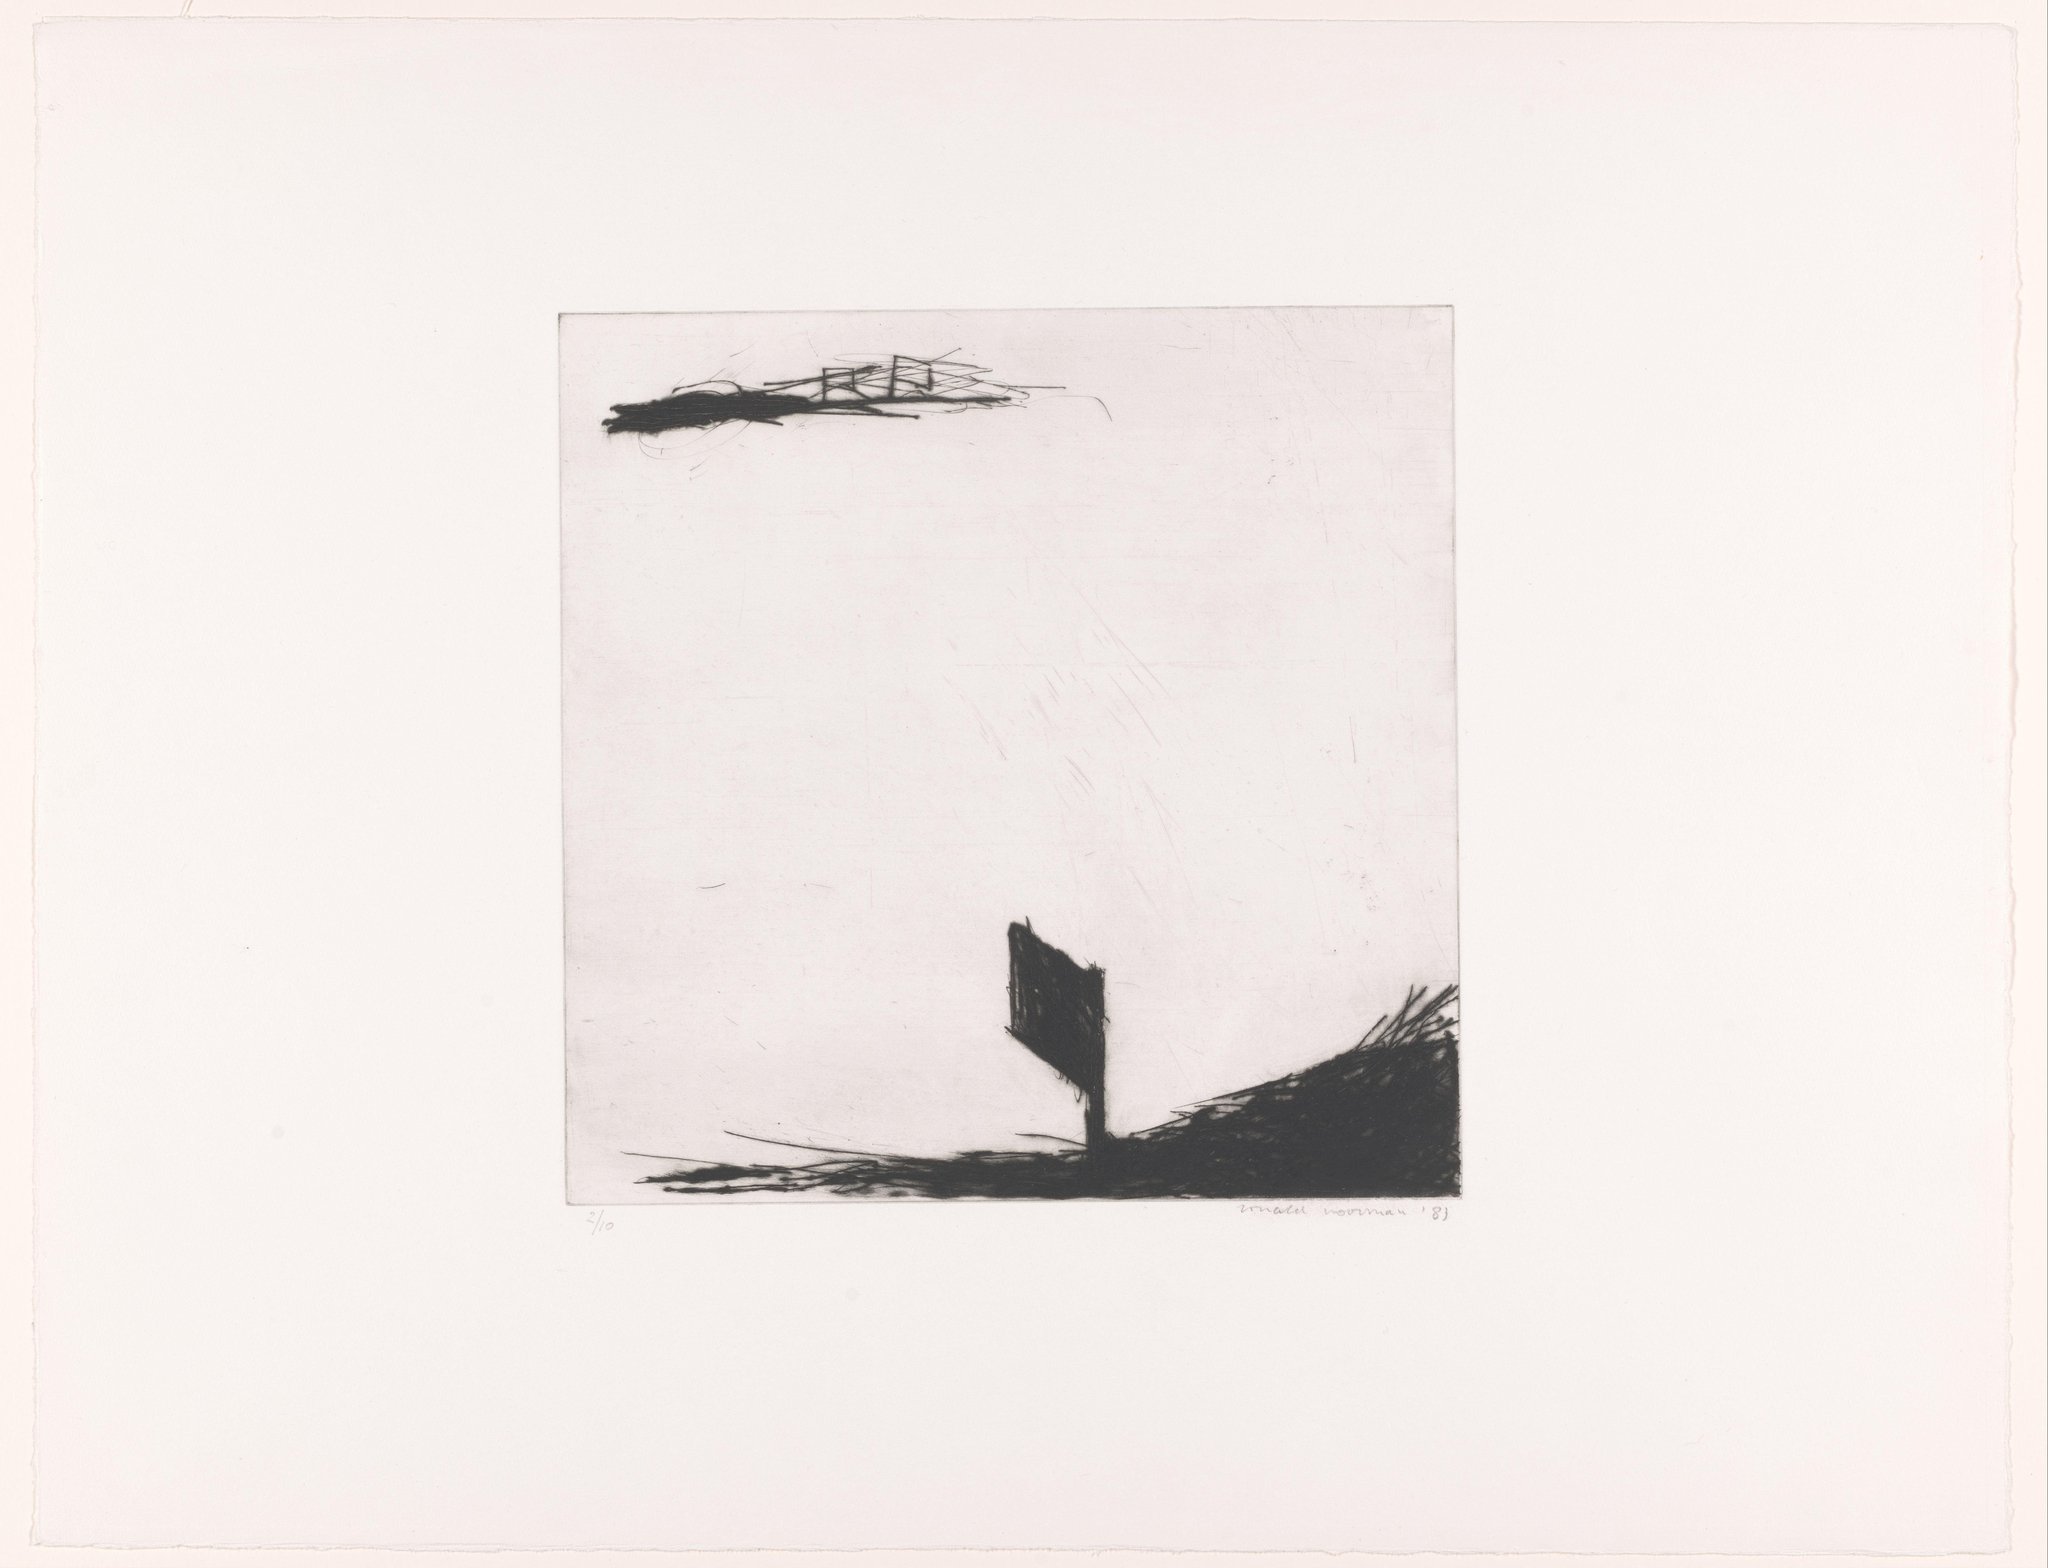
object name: print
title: Vlaggetjes van stijve stukken plastic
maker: ronald noorman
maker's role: draughtsman, print maker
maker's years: 1951-2018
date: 1983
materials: paper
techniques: drypoint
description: Vlaggetjes gemaakt van stijve stukken plastic (kunstmestzakken), die voor de boeren als indicatiepunten dienen om op het juiste moment de machines af te wenden.